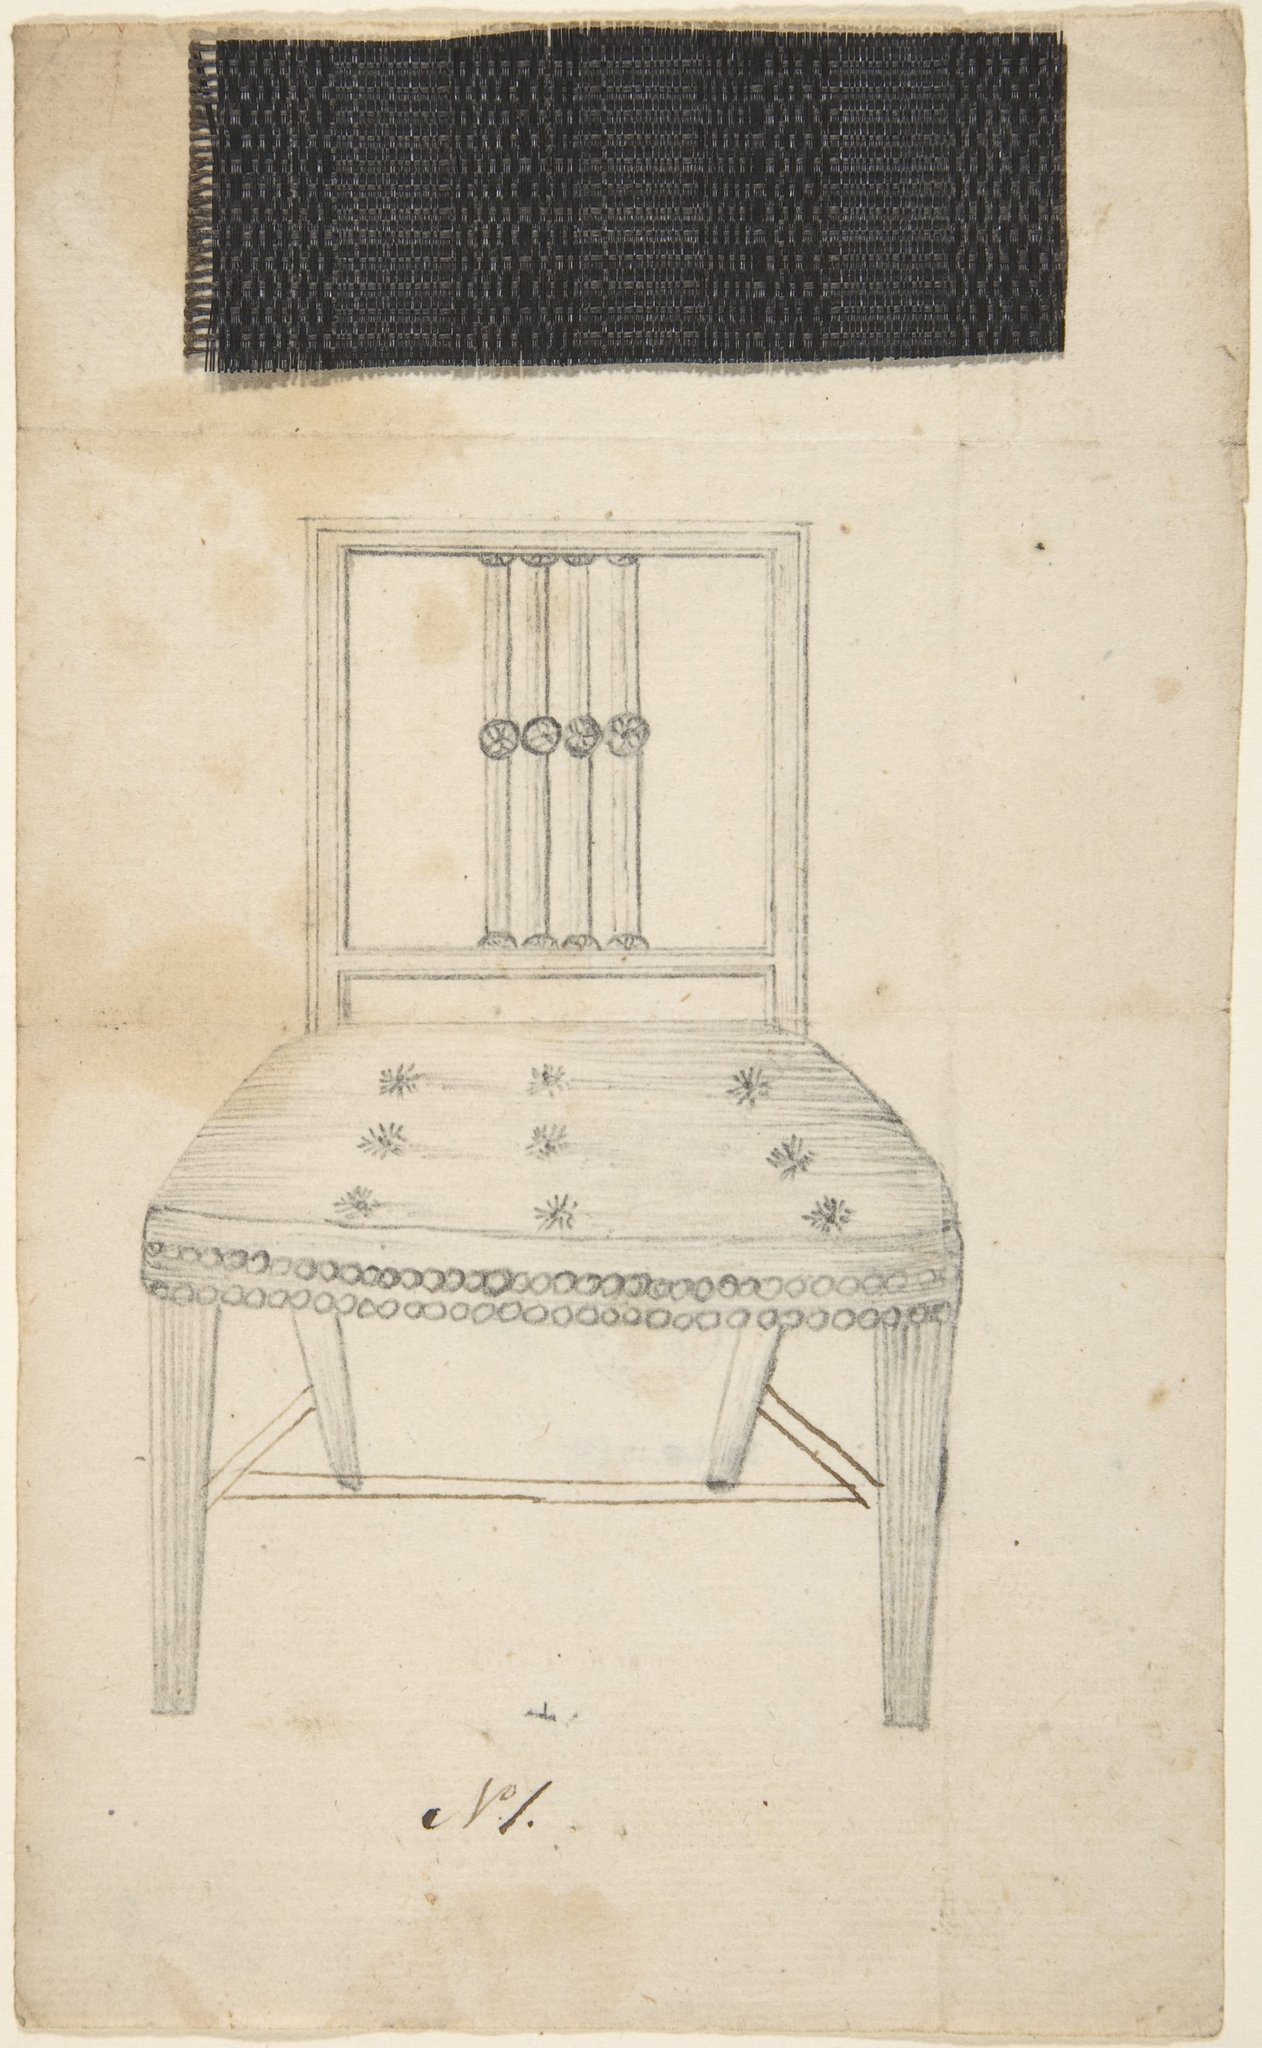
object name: drawing c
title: Two designs for side chairs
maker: anonymous, german, 18th century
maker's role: artist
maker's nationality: german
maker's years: 1700-1800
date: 1701-1800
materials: textile, graphite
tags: chairs